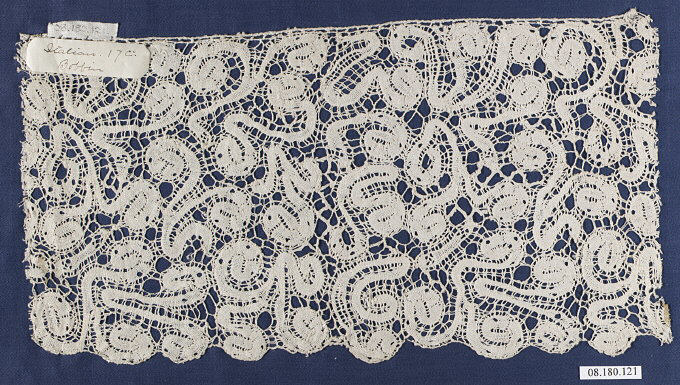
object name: fragment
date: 1667-1700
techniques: lace